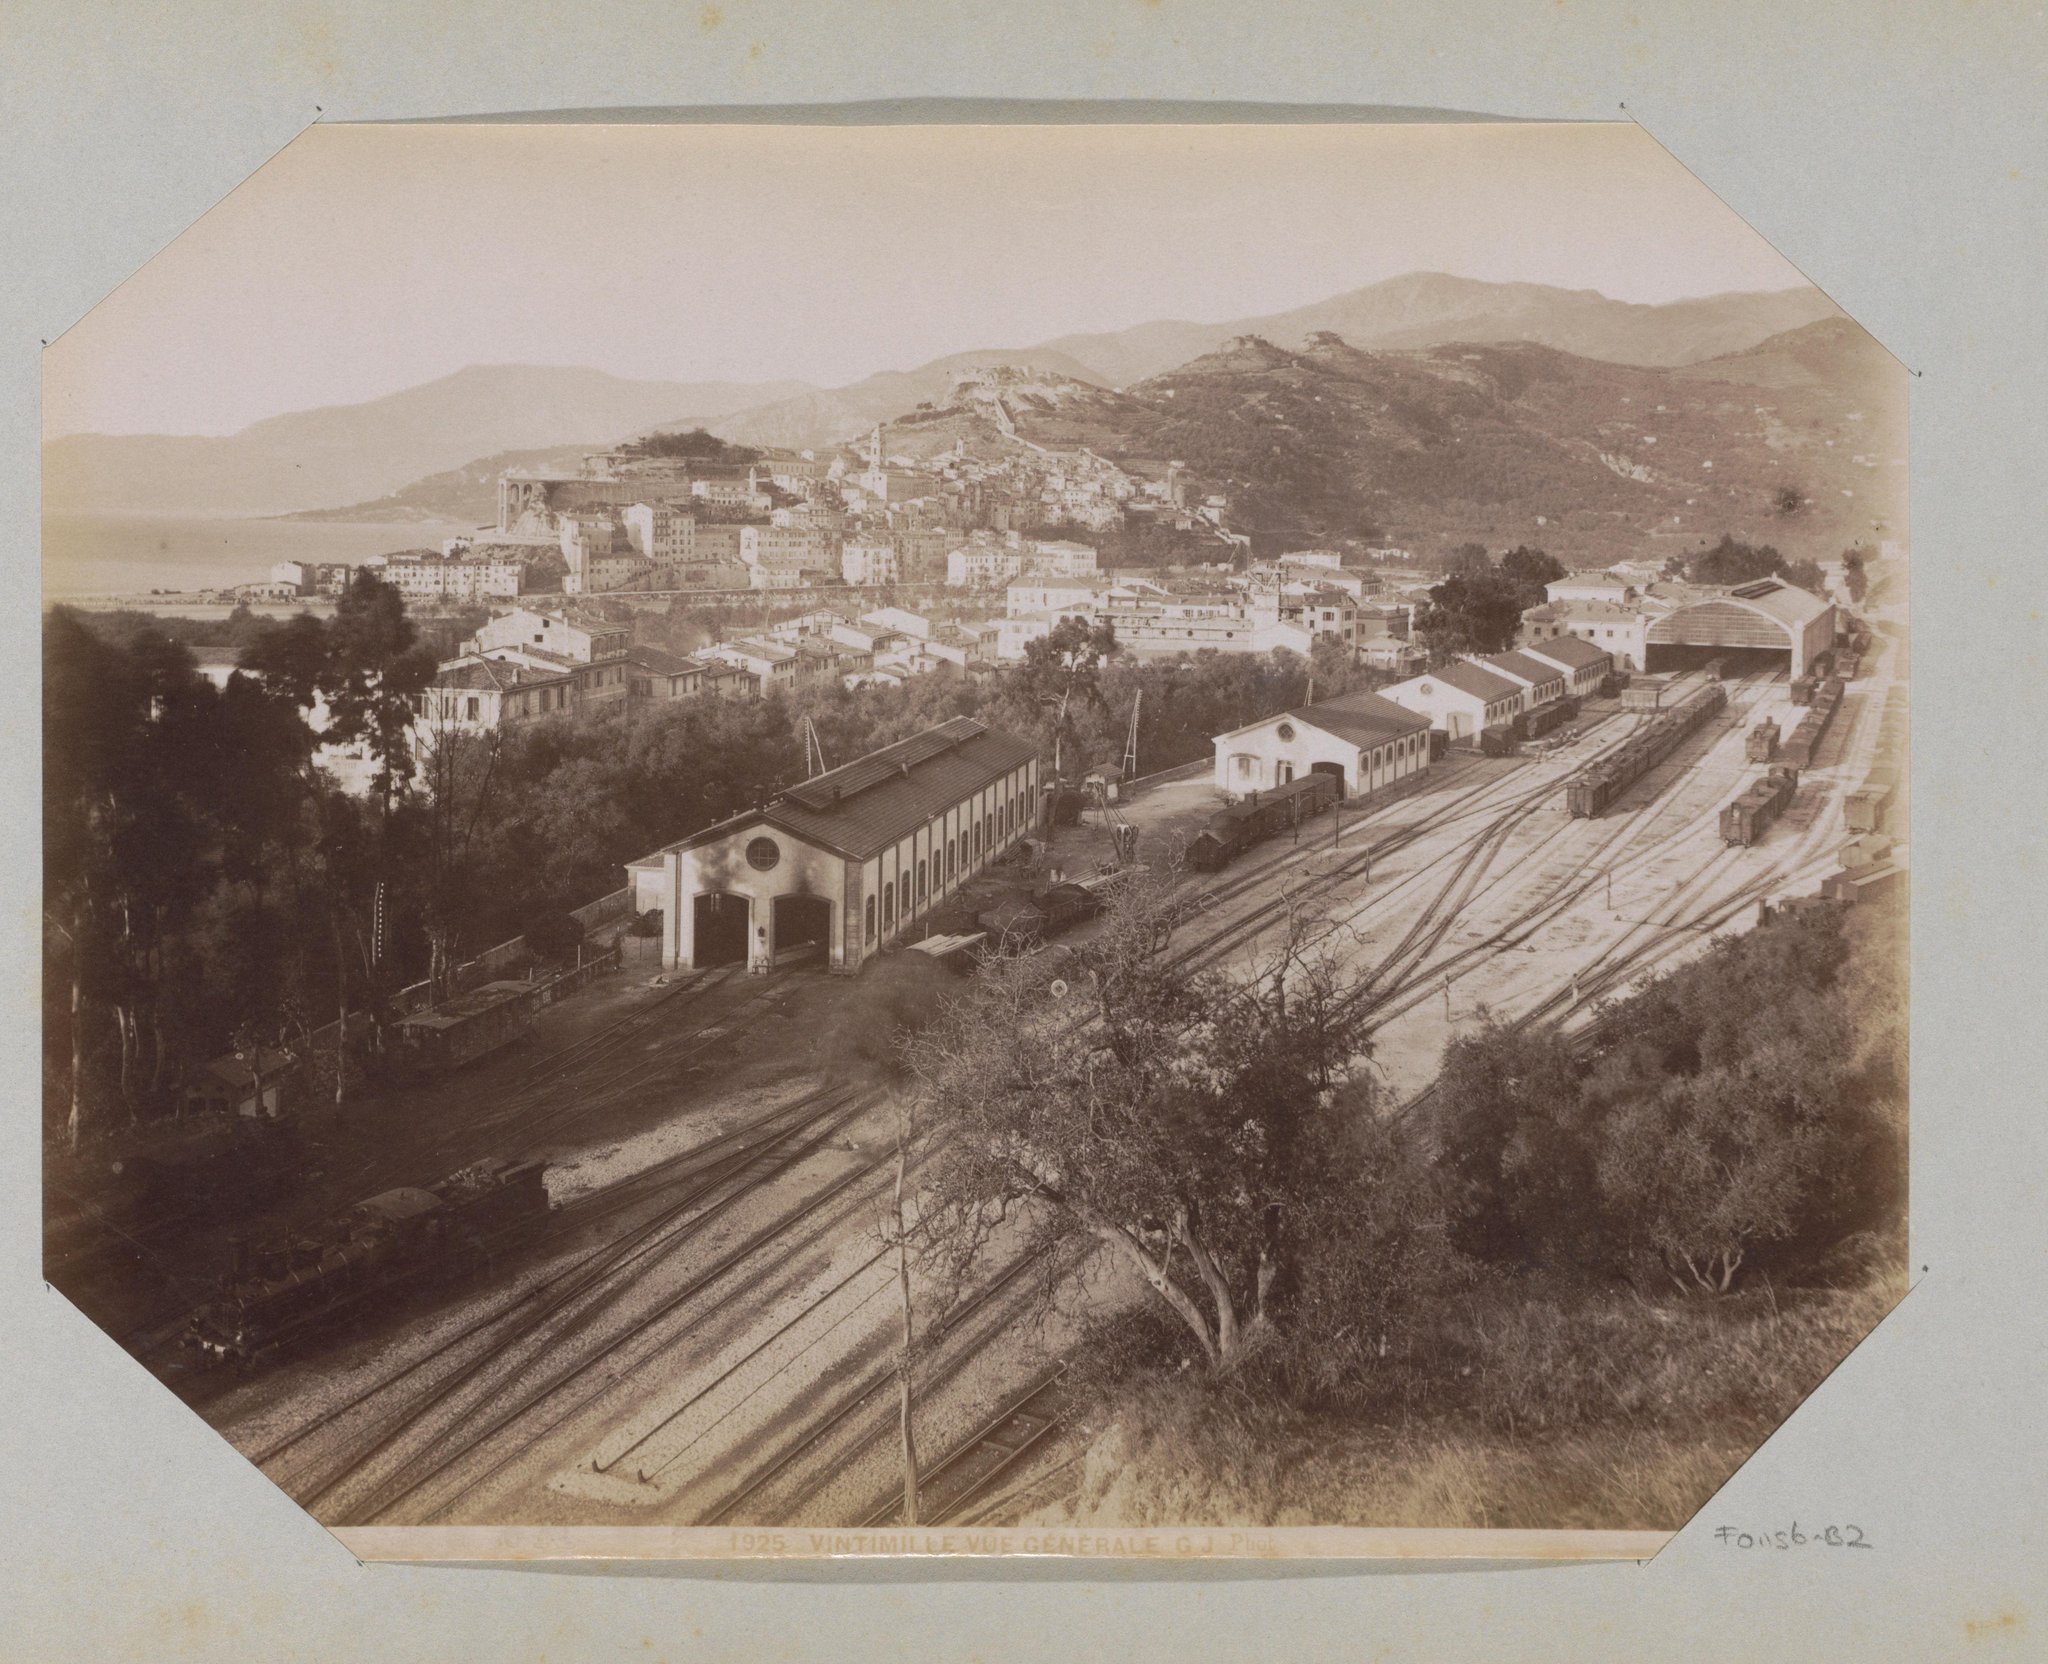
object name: album leaf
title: Gezicht op Ventimiglia met rangeerterrein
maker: jean gilletta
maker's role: fotograaf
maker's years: 1856-1933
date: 1896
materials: photographic support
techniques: albumen print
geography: ventimiglia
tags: city-view in general; 'veduta'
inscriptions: inscription: ‘1925 Vintimille vue générale G.J. Phot.’